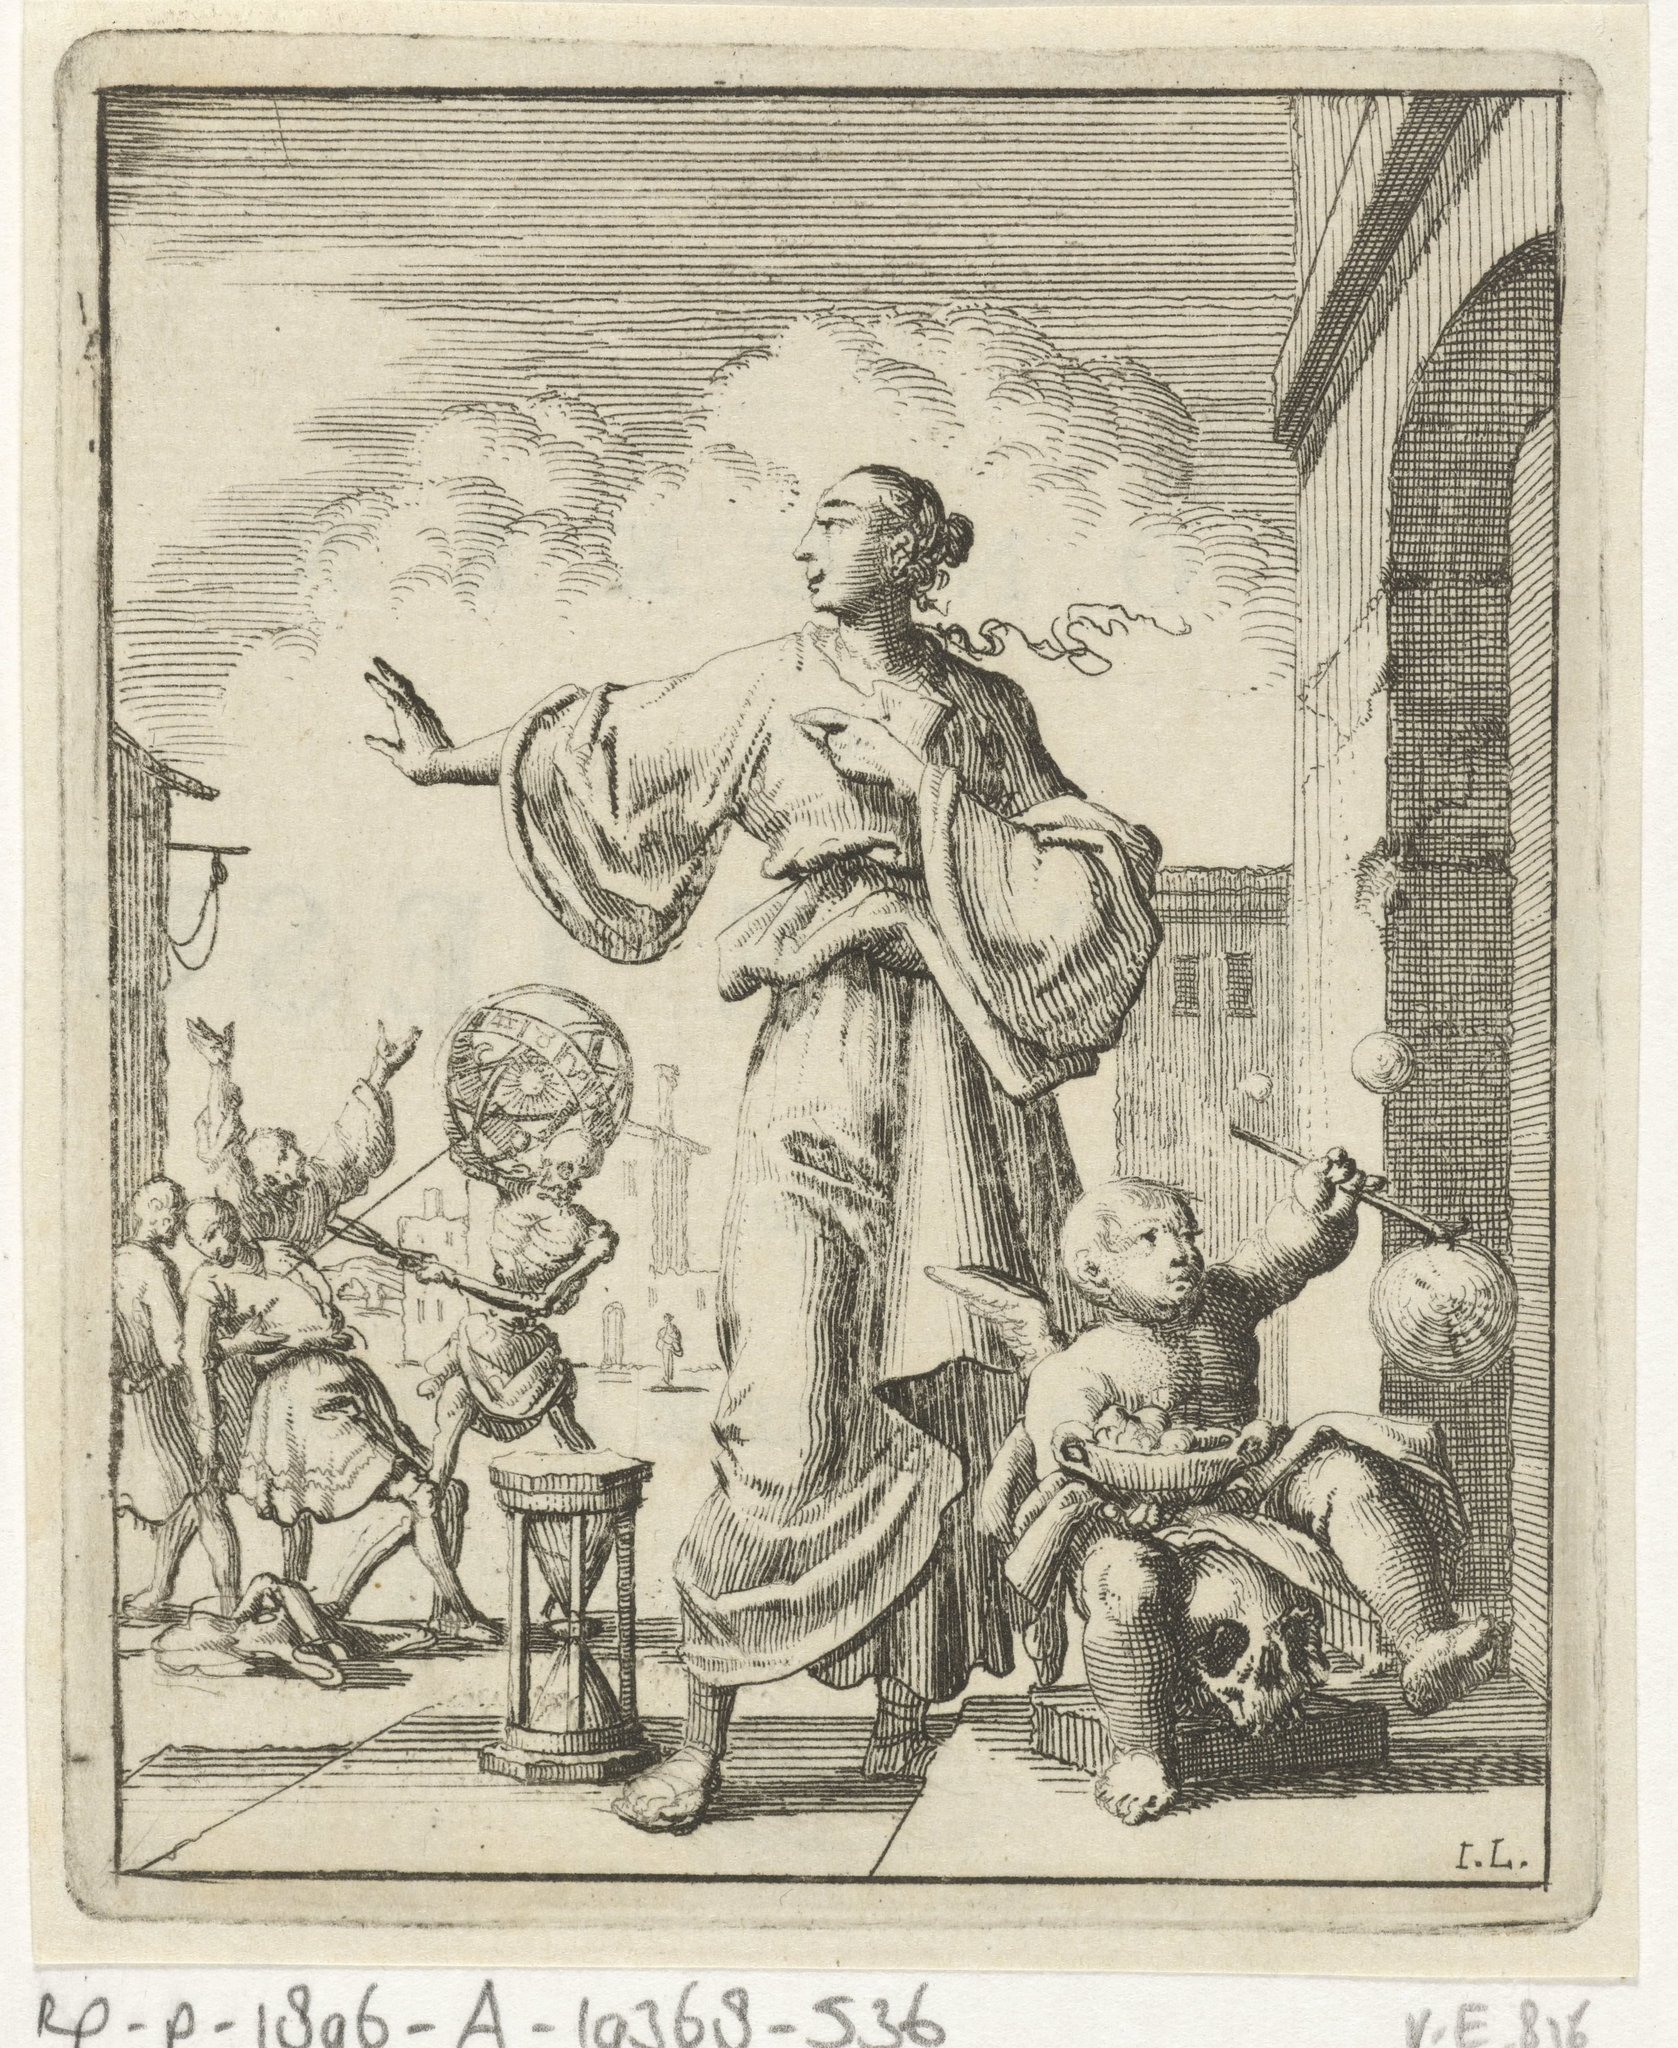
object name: print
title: Wat is 't Leven?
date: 1687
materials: paper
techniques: etching, letterpress printing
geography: amsterdam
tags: symbols of human life, (children or putti) blowing bubbles, 'homo bulla' ~ scene symbolizing 'vanitas', death as skeleton - ff - death as female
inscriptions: collector's mark: Lugt 2228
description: Illustratie uit: Luyken, Jan. Voncken der liefde Jesu, van het godtbegerende zielenvier. Amsterdam: Pieter Arentsz (II), 1687, p. 2.